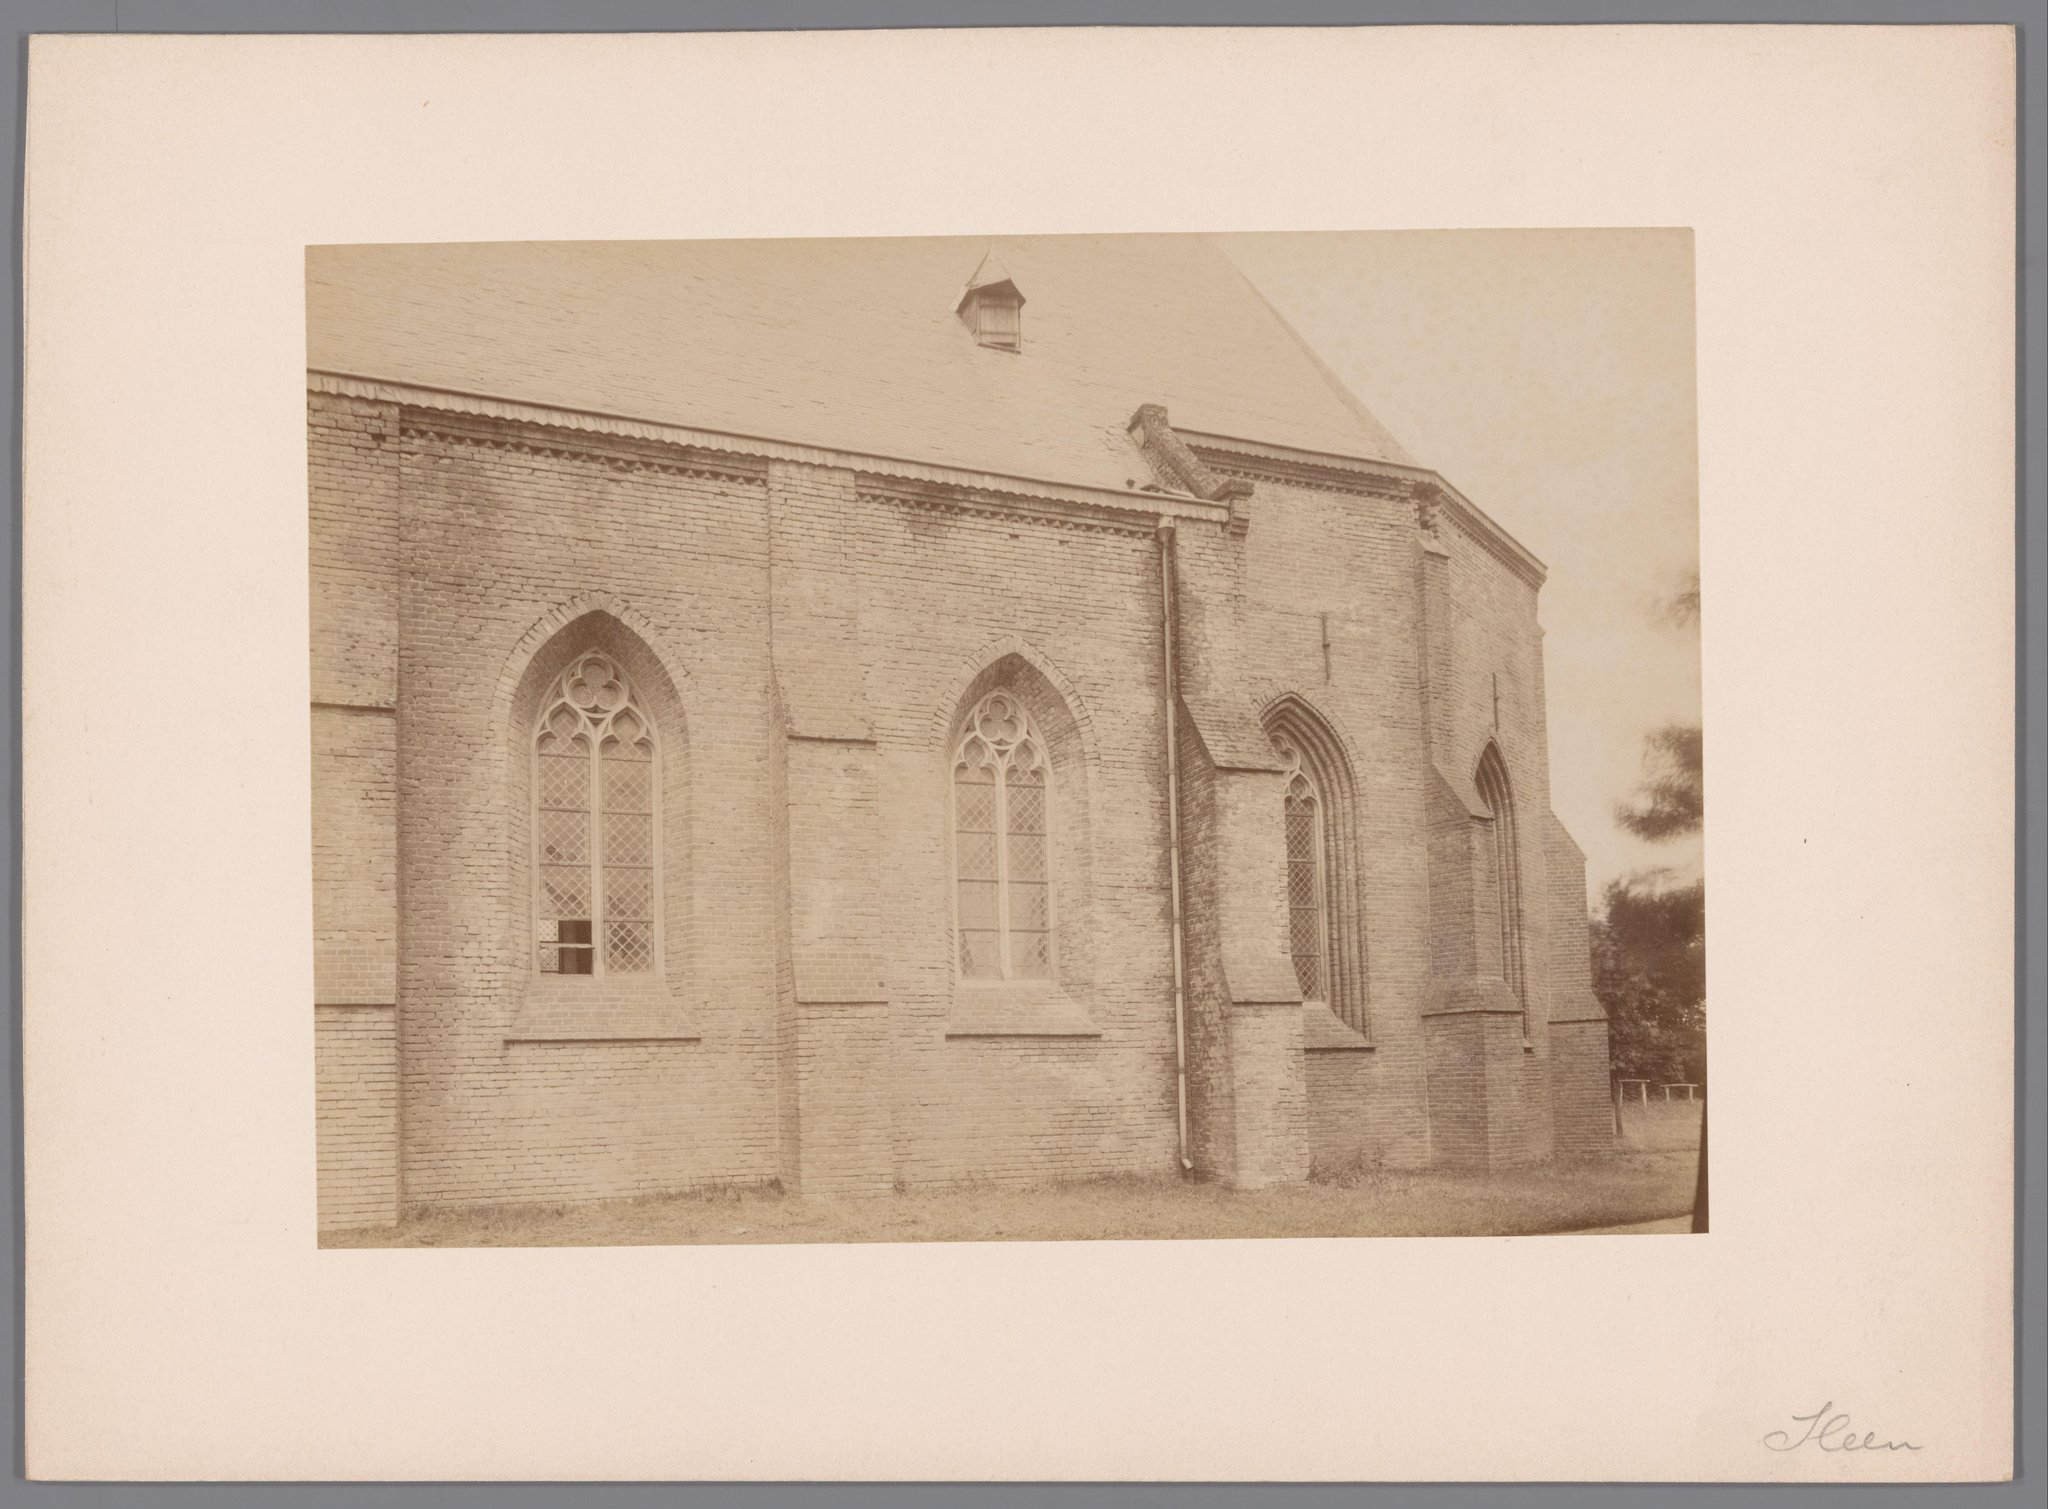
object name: photograph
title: Gedeelte van de Hervormde Kerk te Sleen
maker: anoniem (monumentenzorg)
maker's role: fotograaf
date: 1903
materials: cardboard, photographic support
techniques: albumen print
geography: sleen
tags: church (exterior)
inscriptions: annotation: ‘Sleen (Drenthe)/ kerk der N.H. gemeente/ juli 1903’, annotation: ‘Sleen’